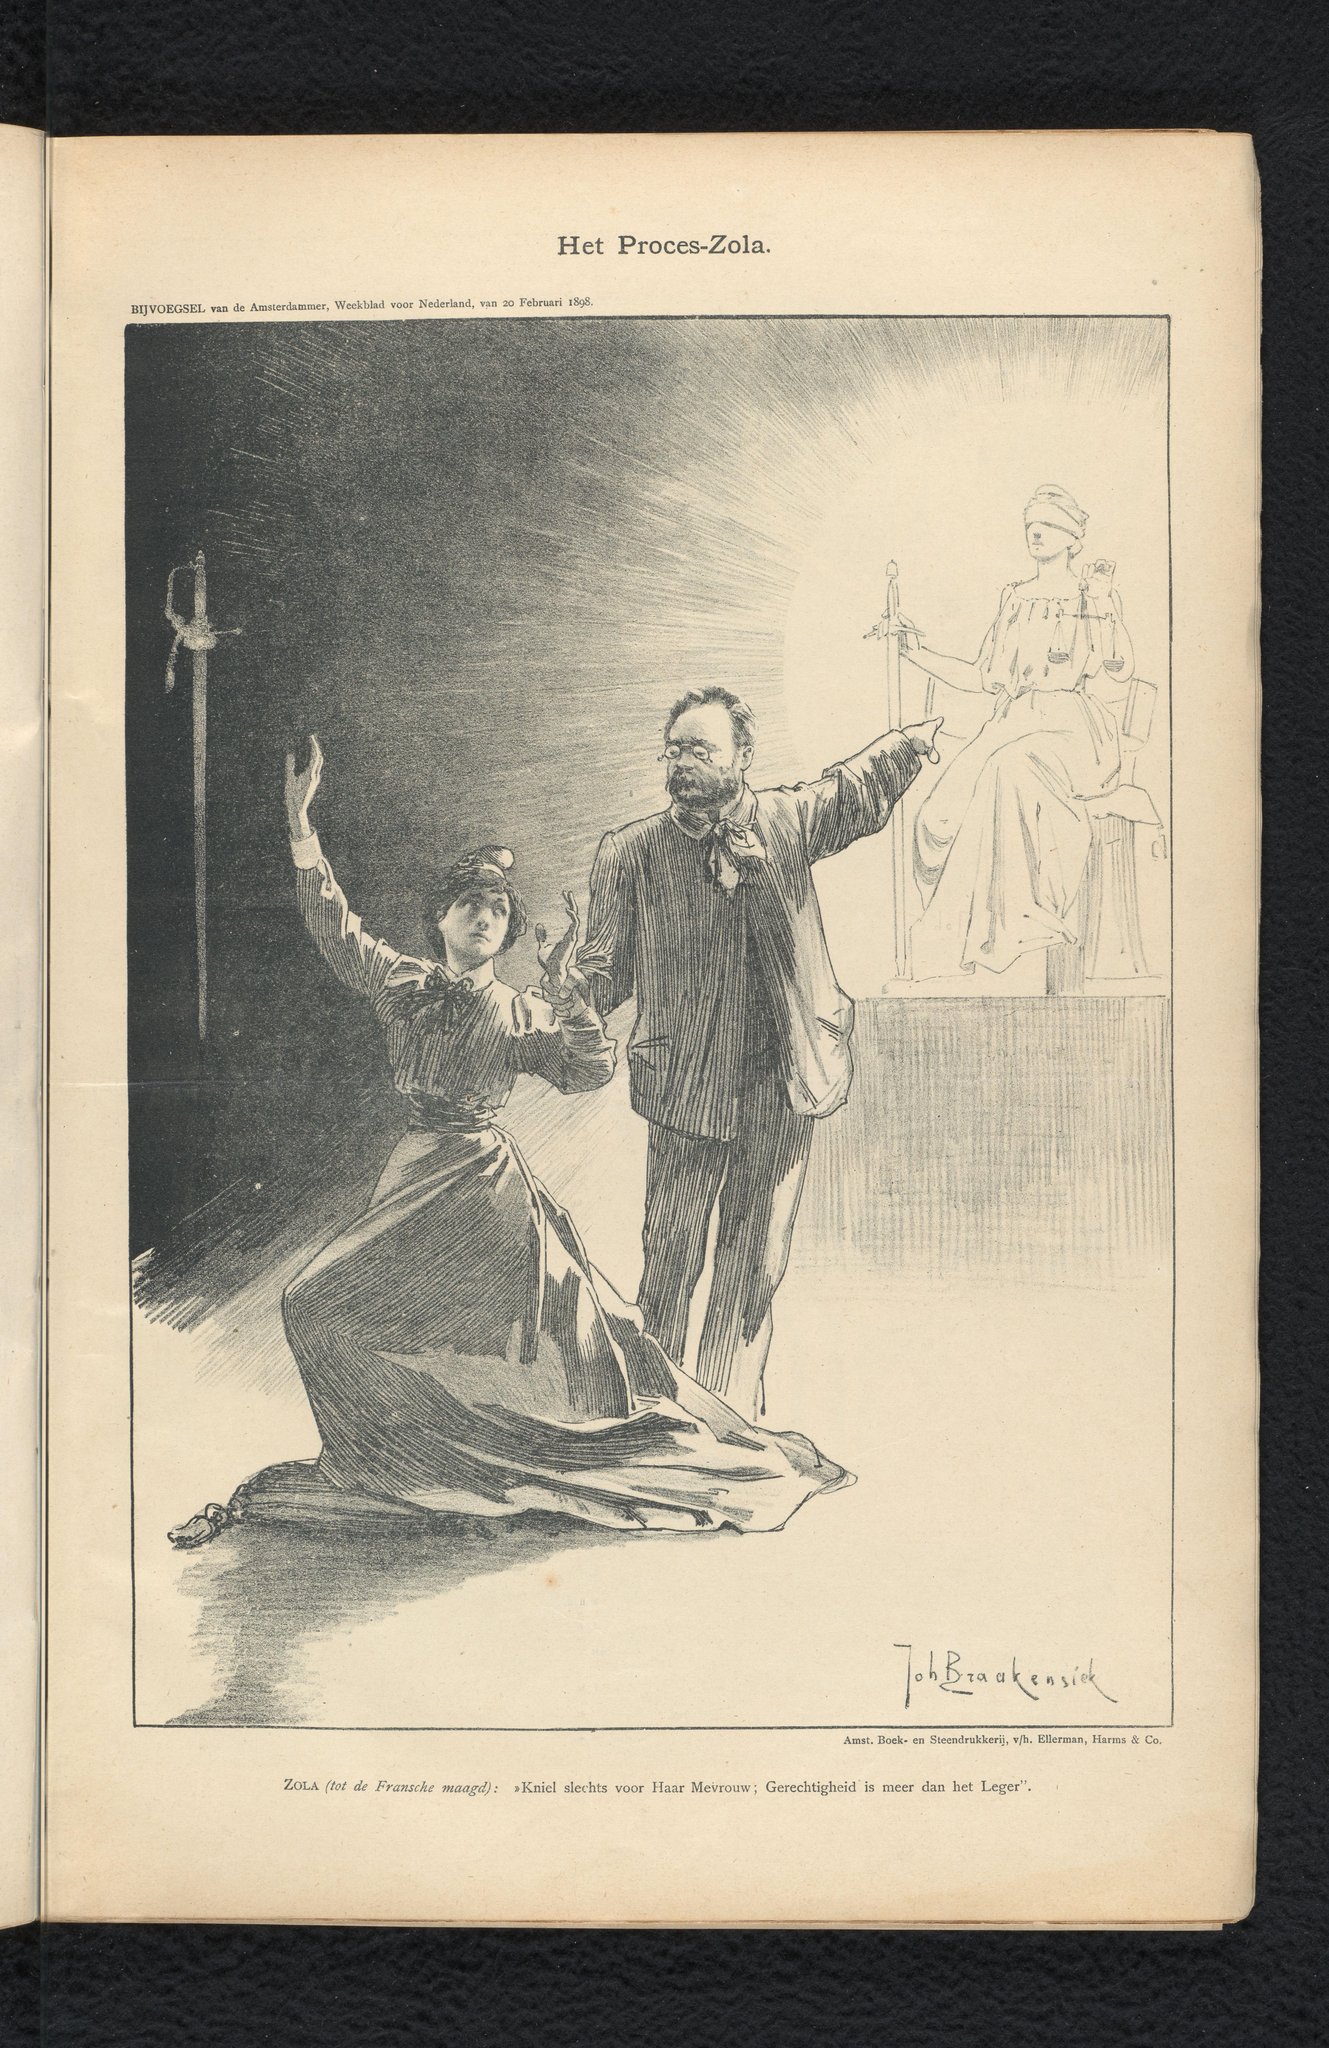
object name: cartoon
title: Het Proces-Zola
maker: johan braakensiek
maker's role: draughtsman, print maker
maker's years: 1858-1940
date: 1898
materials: paper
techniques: lithograph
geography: amsterdam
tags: paris, emile zola, justice, 'justitia'; 'giustitia divina' (ripa) ~ one of the four cardinal virtues, personifications of countries, nations, states, districts, etc., political caricatures and satires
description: Emile Zola laat de Franse Maagd knielen voor het stralende beeld van Justitia. Naar aanleiding van de Dreyfusaffaire.